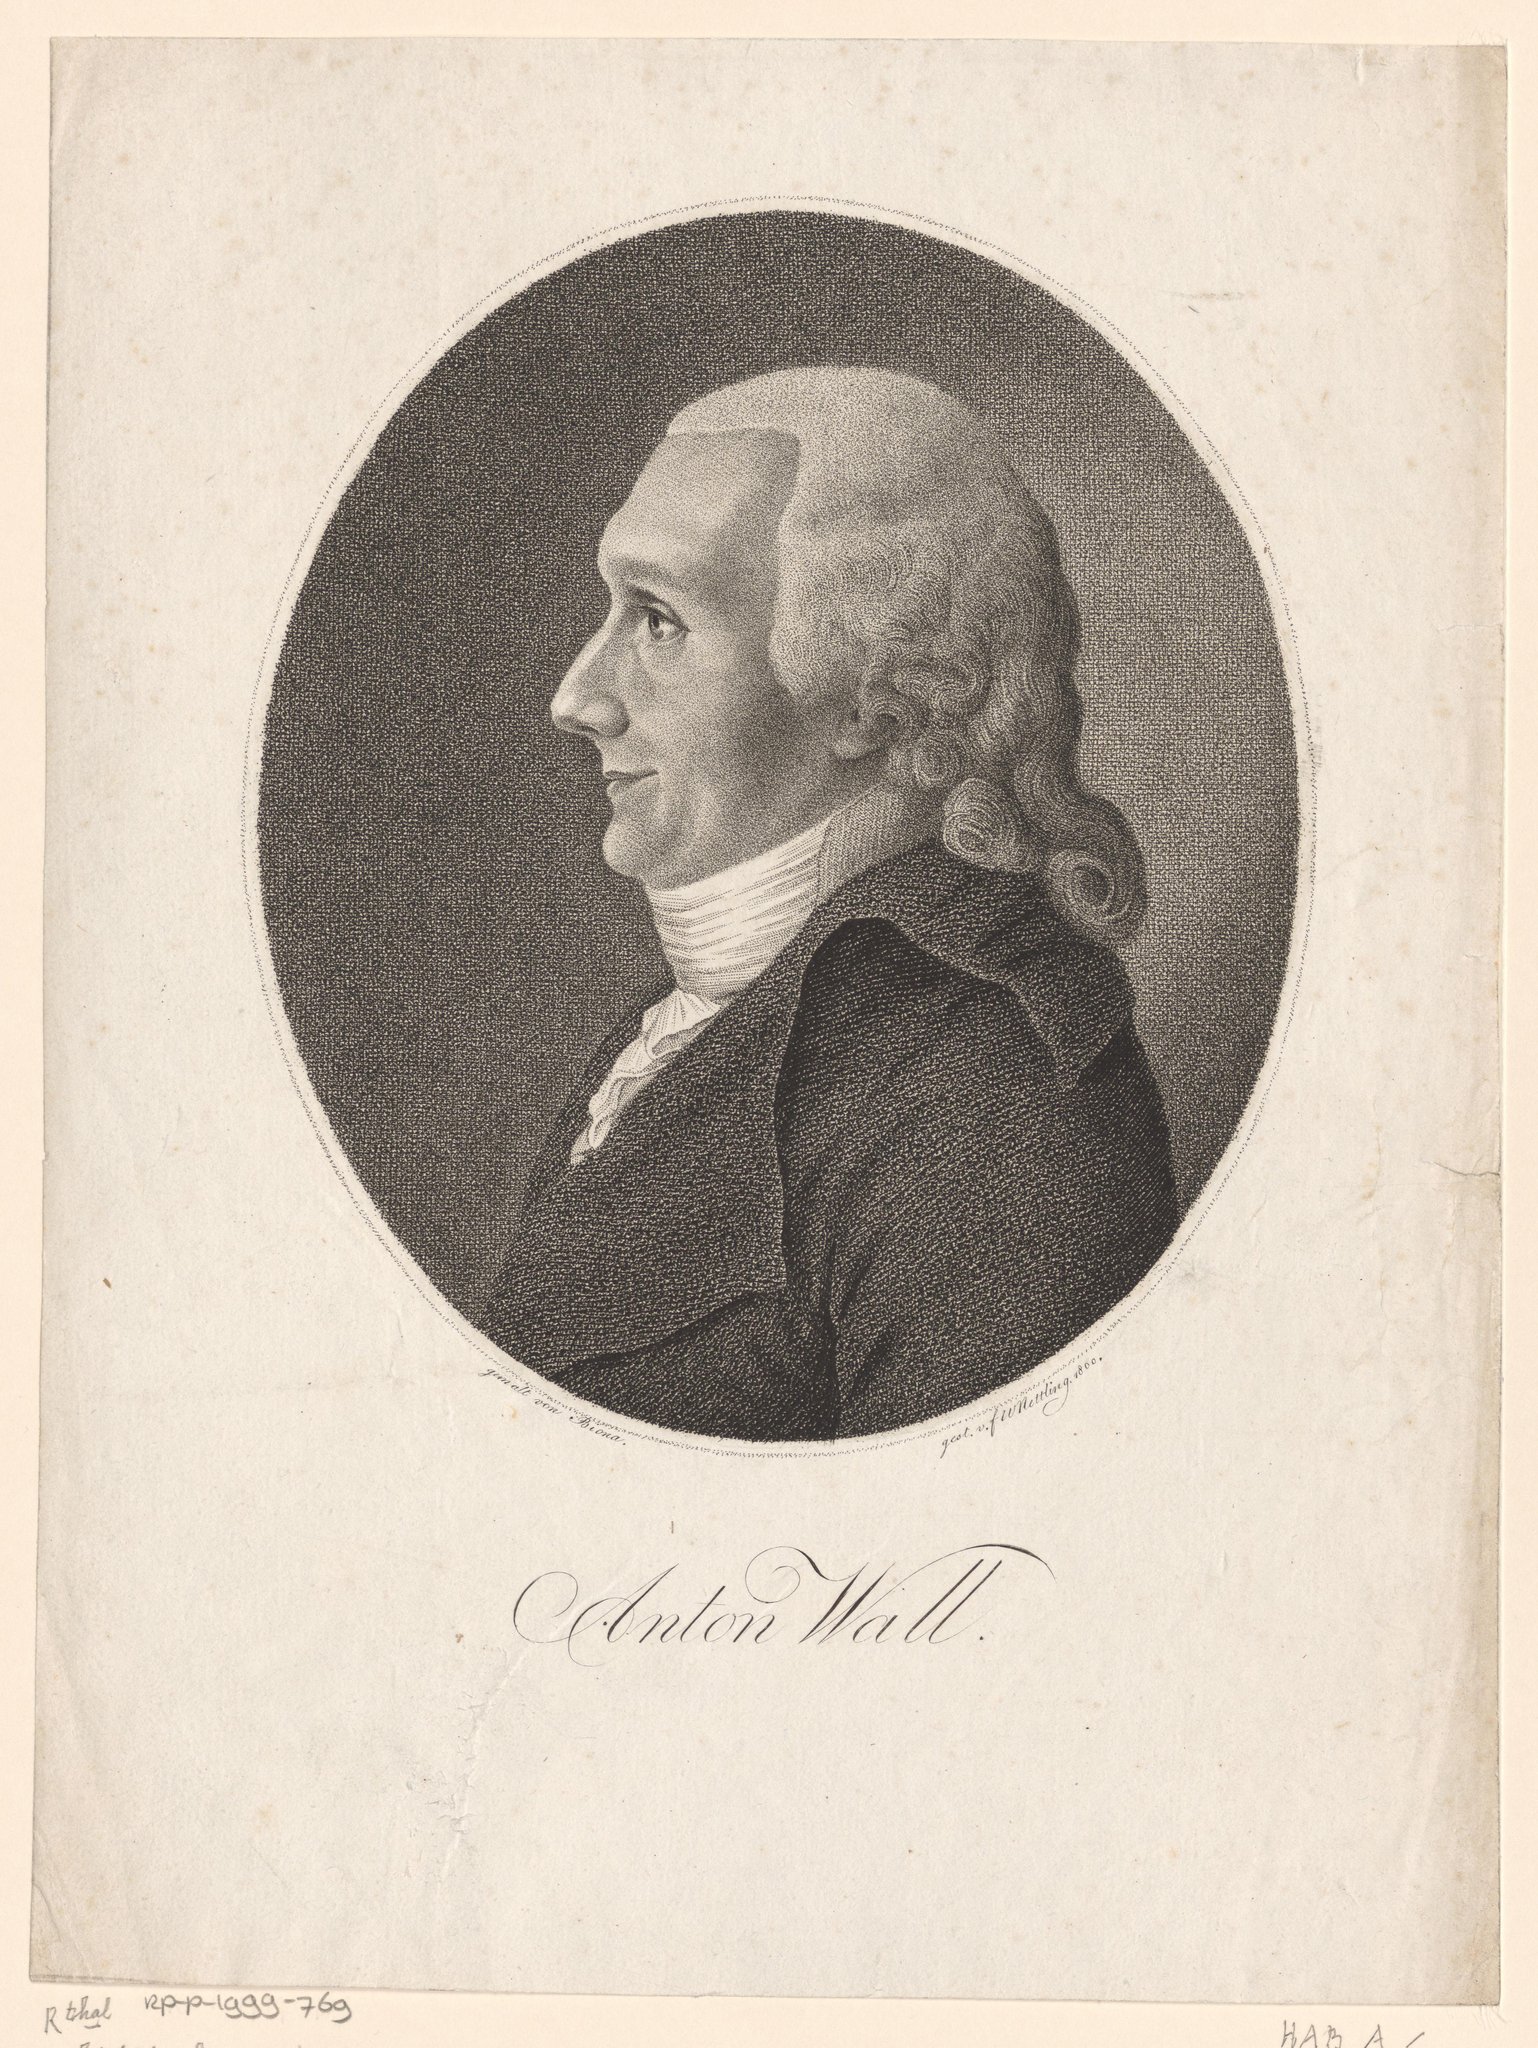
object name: print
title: Portret van Christian Leberecht Heyne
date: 1800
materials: paper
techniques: engraving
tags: historical persons, lawyer, attorney at law, portrait of a writer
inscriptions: collector's mark: Lugt 2228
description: Geportretteerde ook bekend onder het pseudoniem Anton Wall. Buste naar links, in ovaal, tegen zwarte achtergrond.